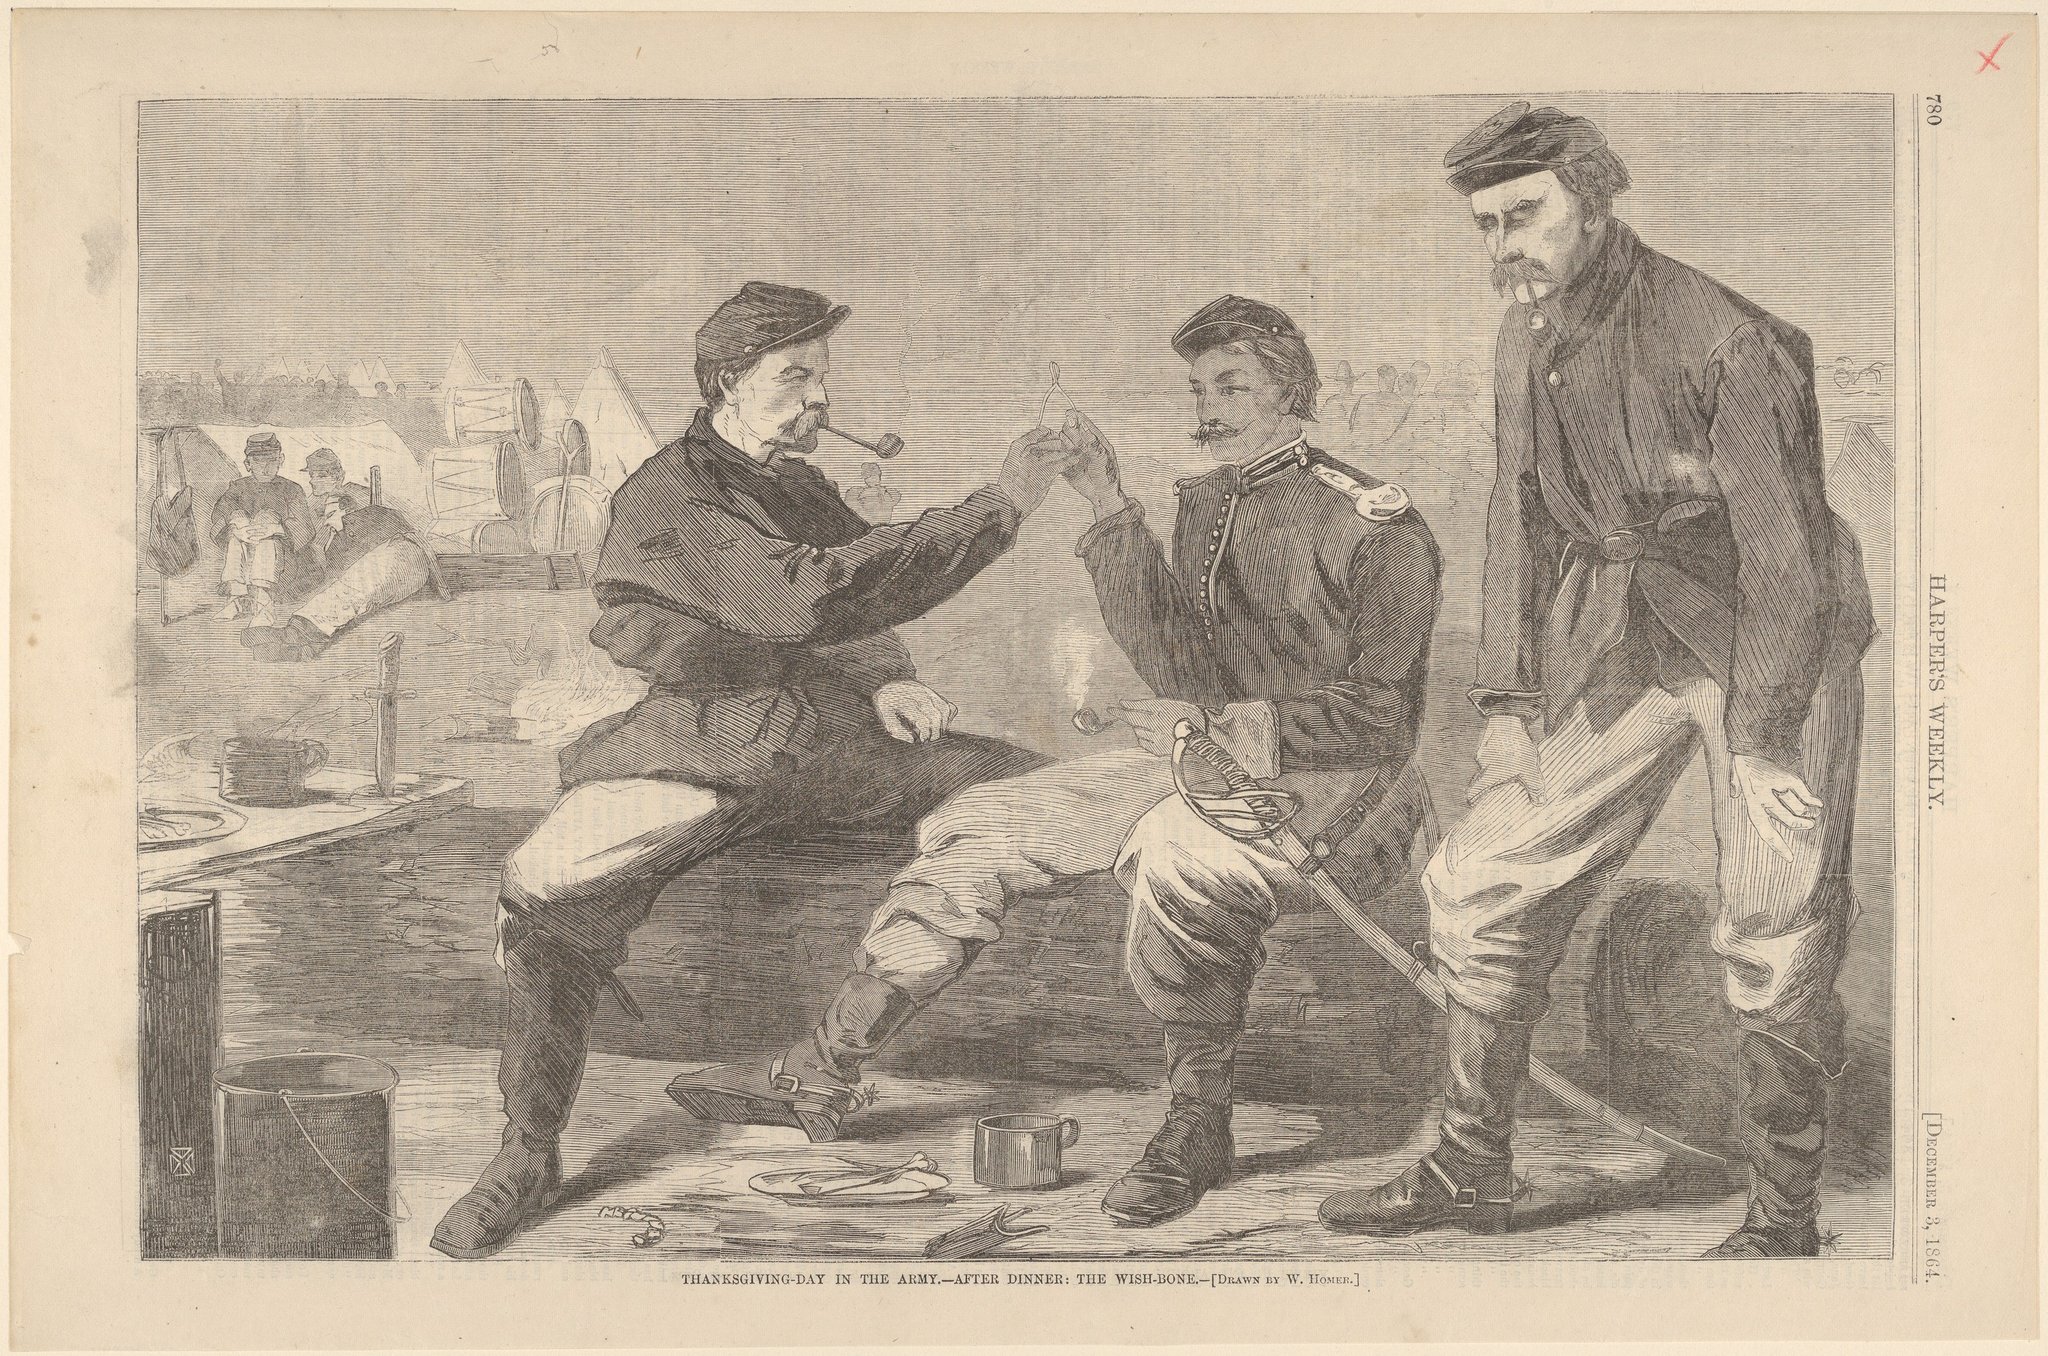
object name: print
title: Thanksgiving Day in the Army – After Dinner: The Wish-Bone (from "Harper's Weekly," Vol. VIII)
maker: winslow homer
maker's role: artist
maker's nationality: american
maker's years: 1836-1910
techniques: engraving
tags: soldiers,american civil war,men,smoking